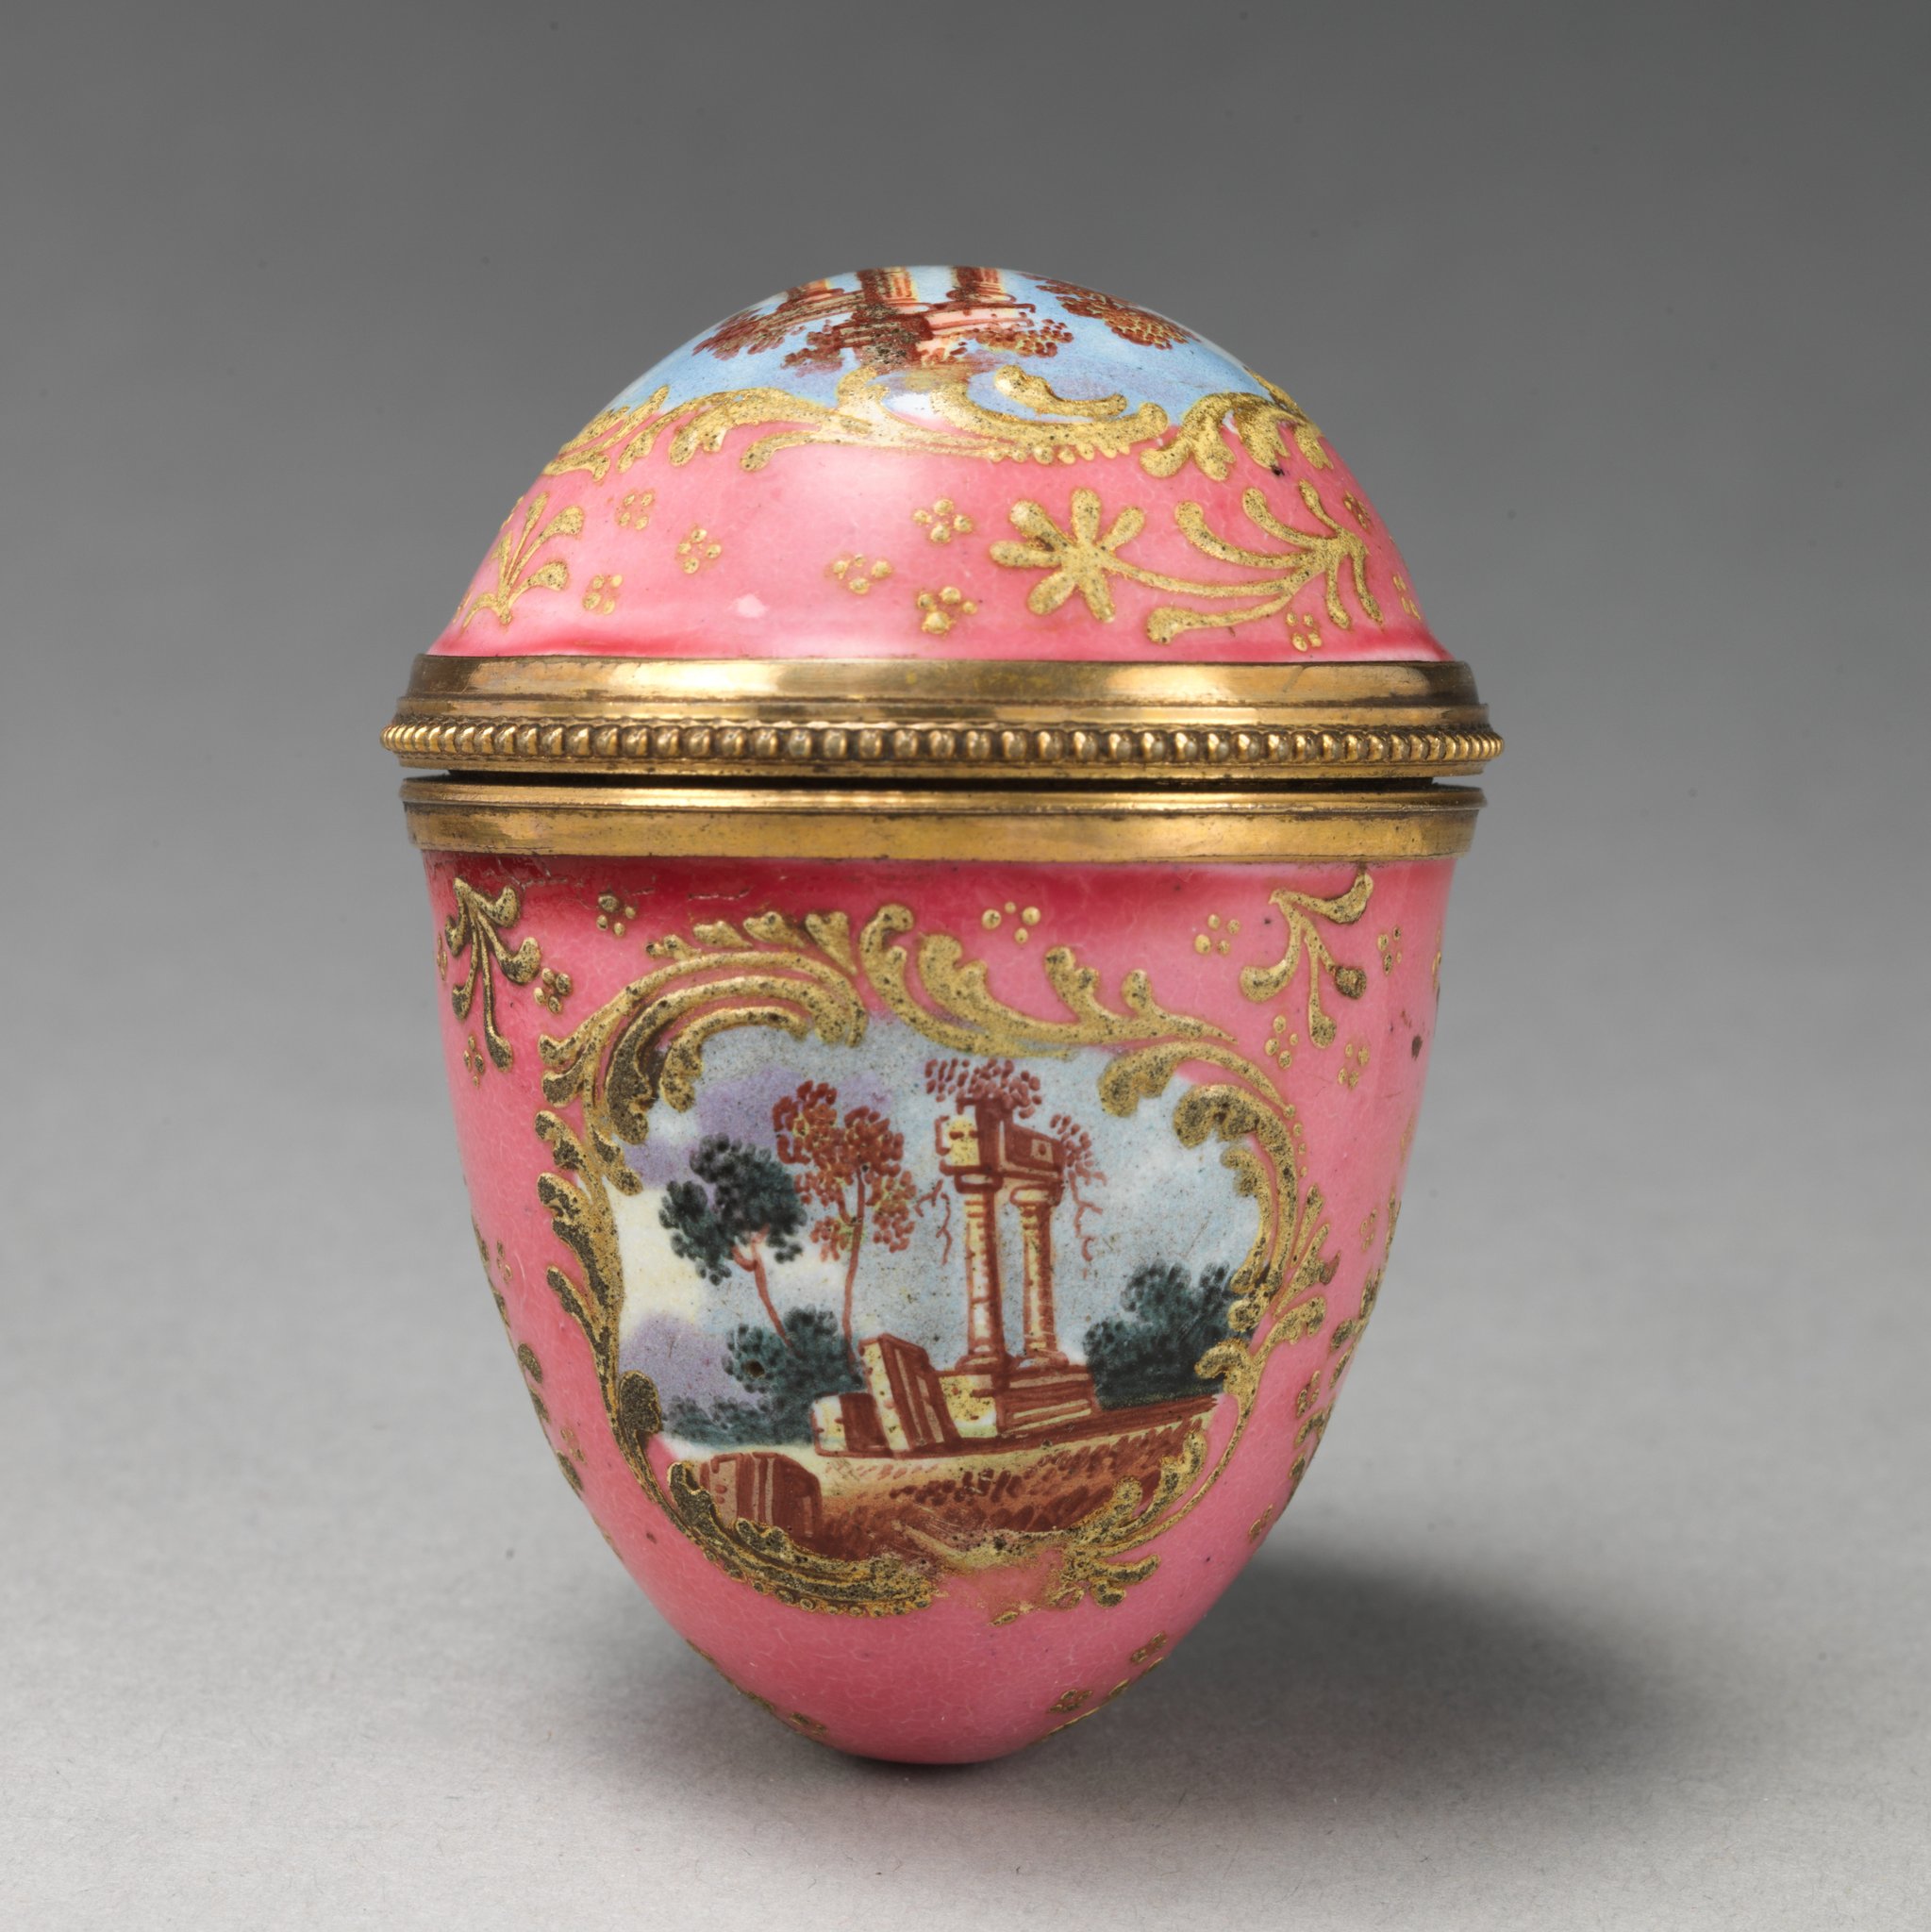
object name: egg shaped box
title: possibly Thimble case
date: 1765-1770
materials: copper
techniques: enamel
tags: trees